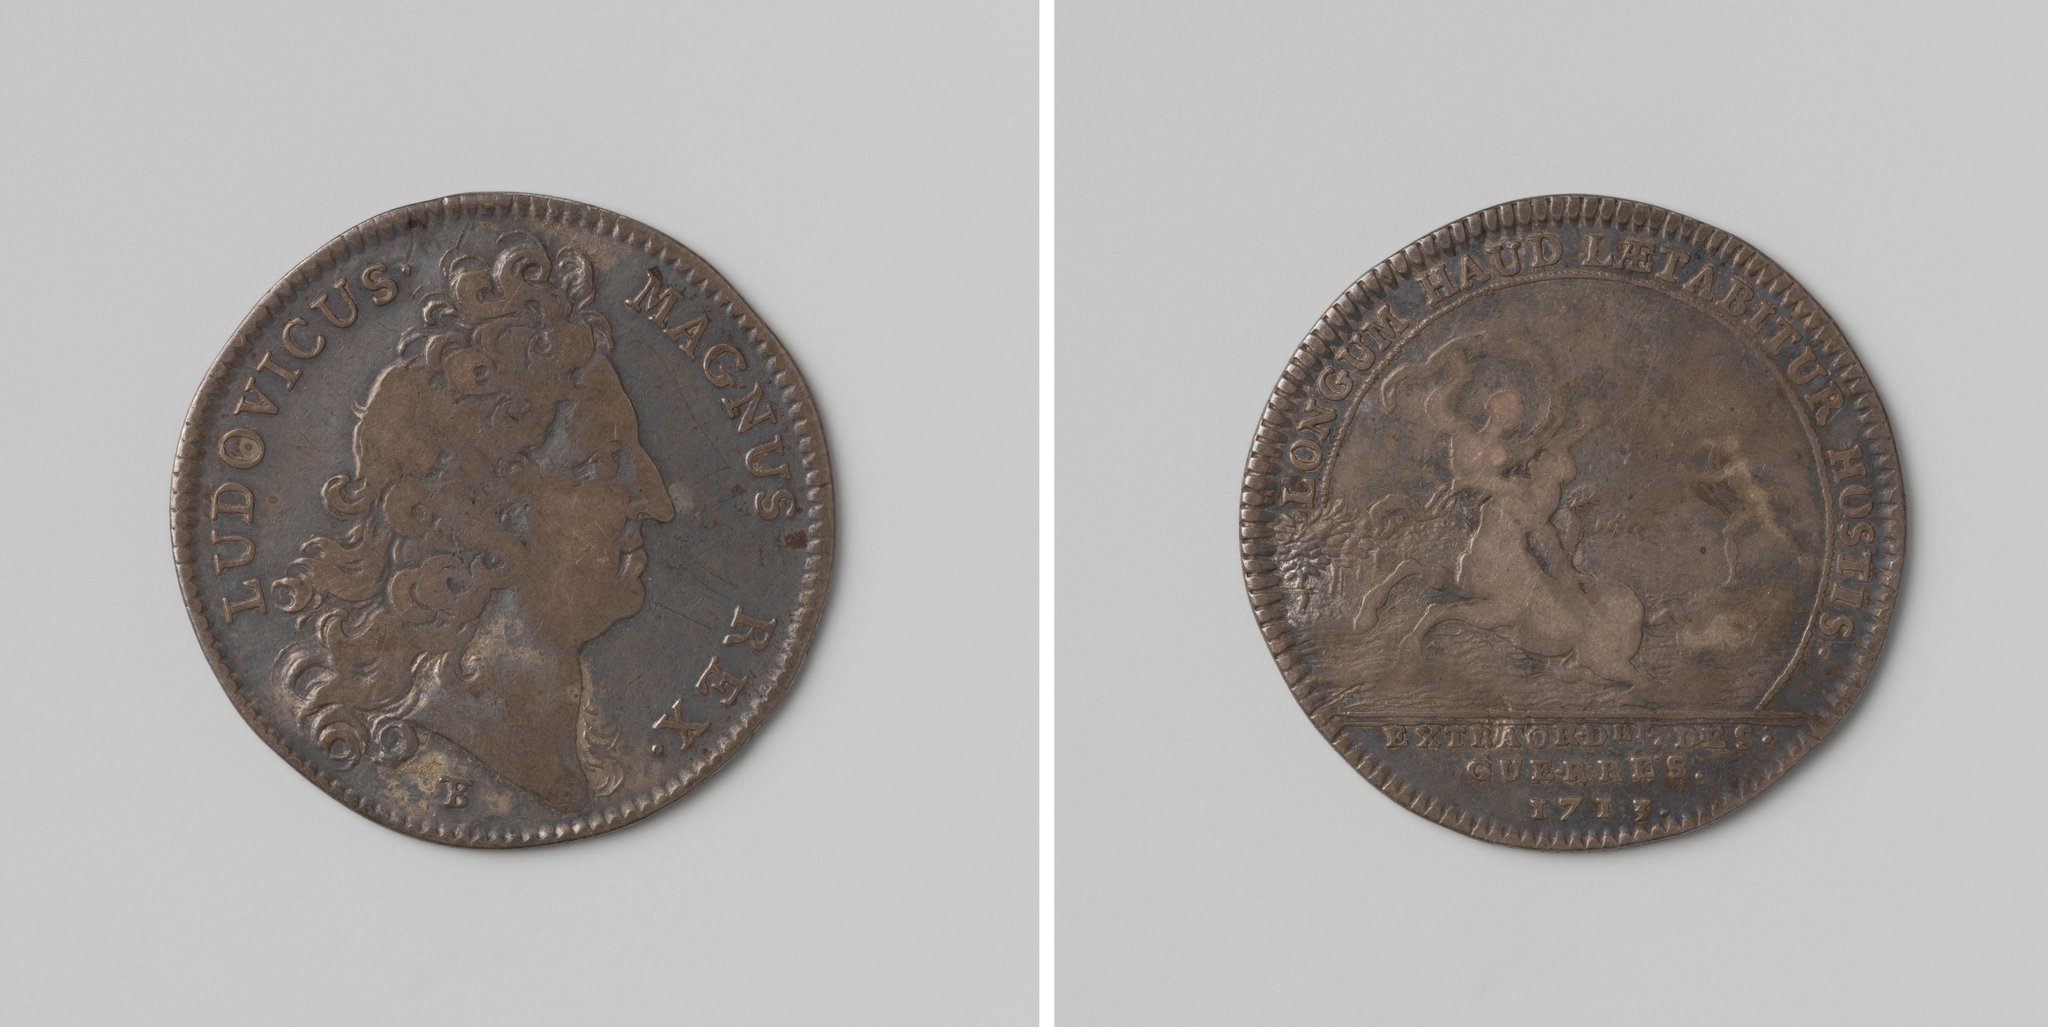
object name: jeton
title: Engeland laat de geallieerden in de steek, rekenpenning geslagen ter ere van Lodewijk XIV, koning van Frankrijk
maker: thomas bernard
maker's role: artist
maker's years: 1650-1713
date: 1713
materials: silver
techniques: striking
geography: paris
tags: lodewijk xiv (koning van frankrijk)